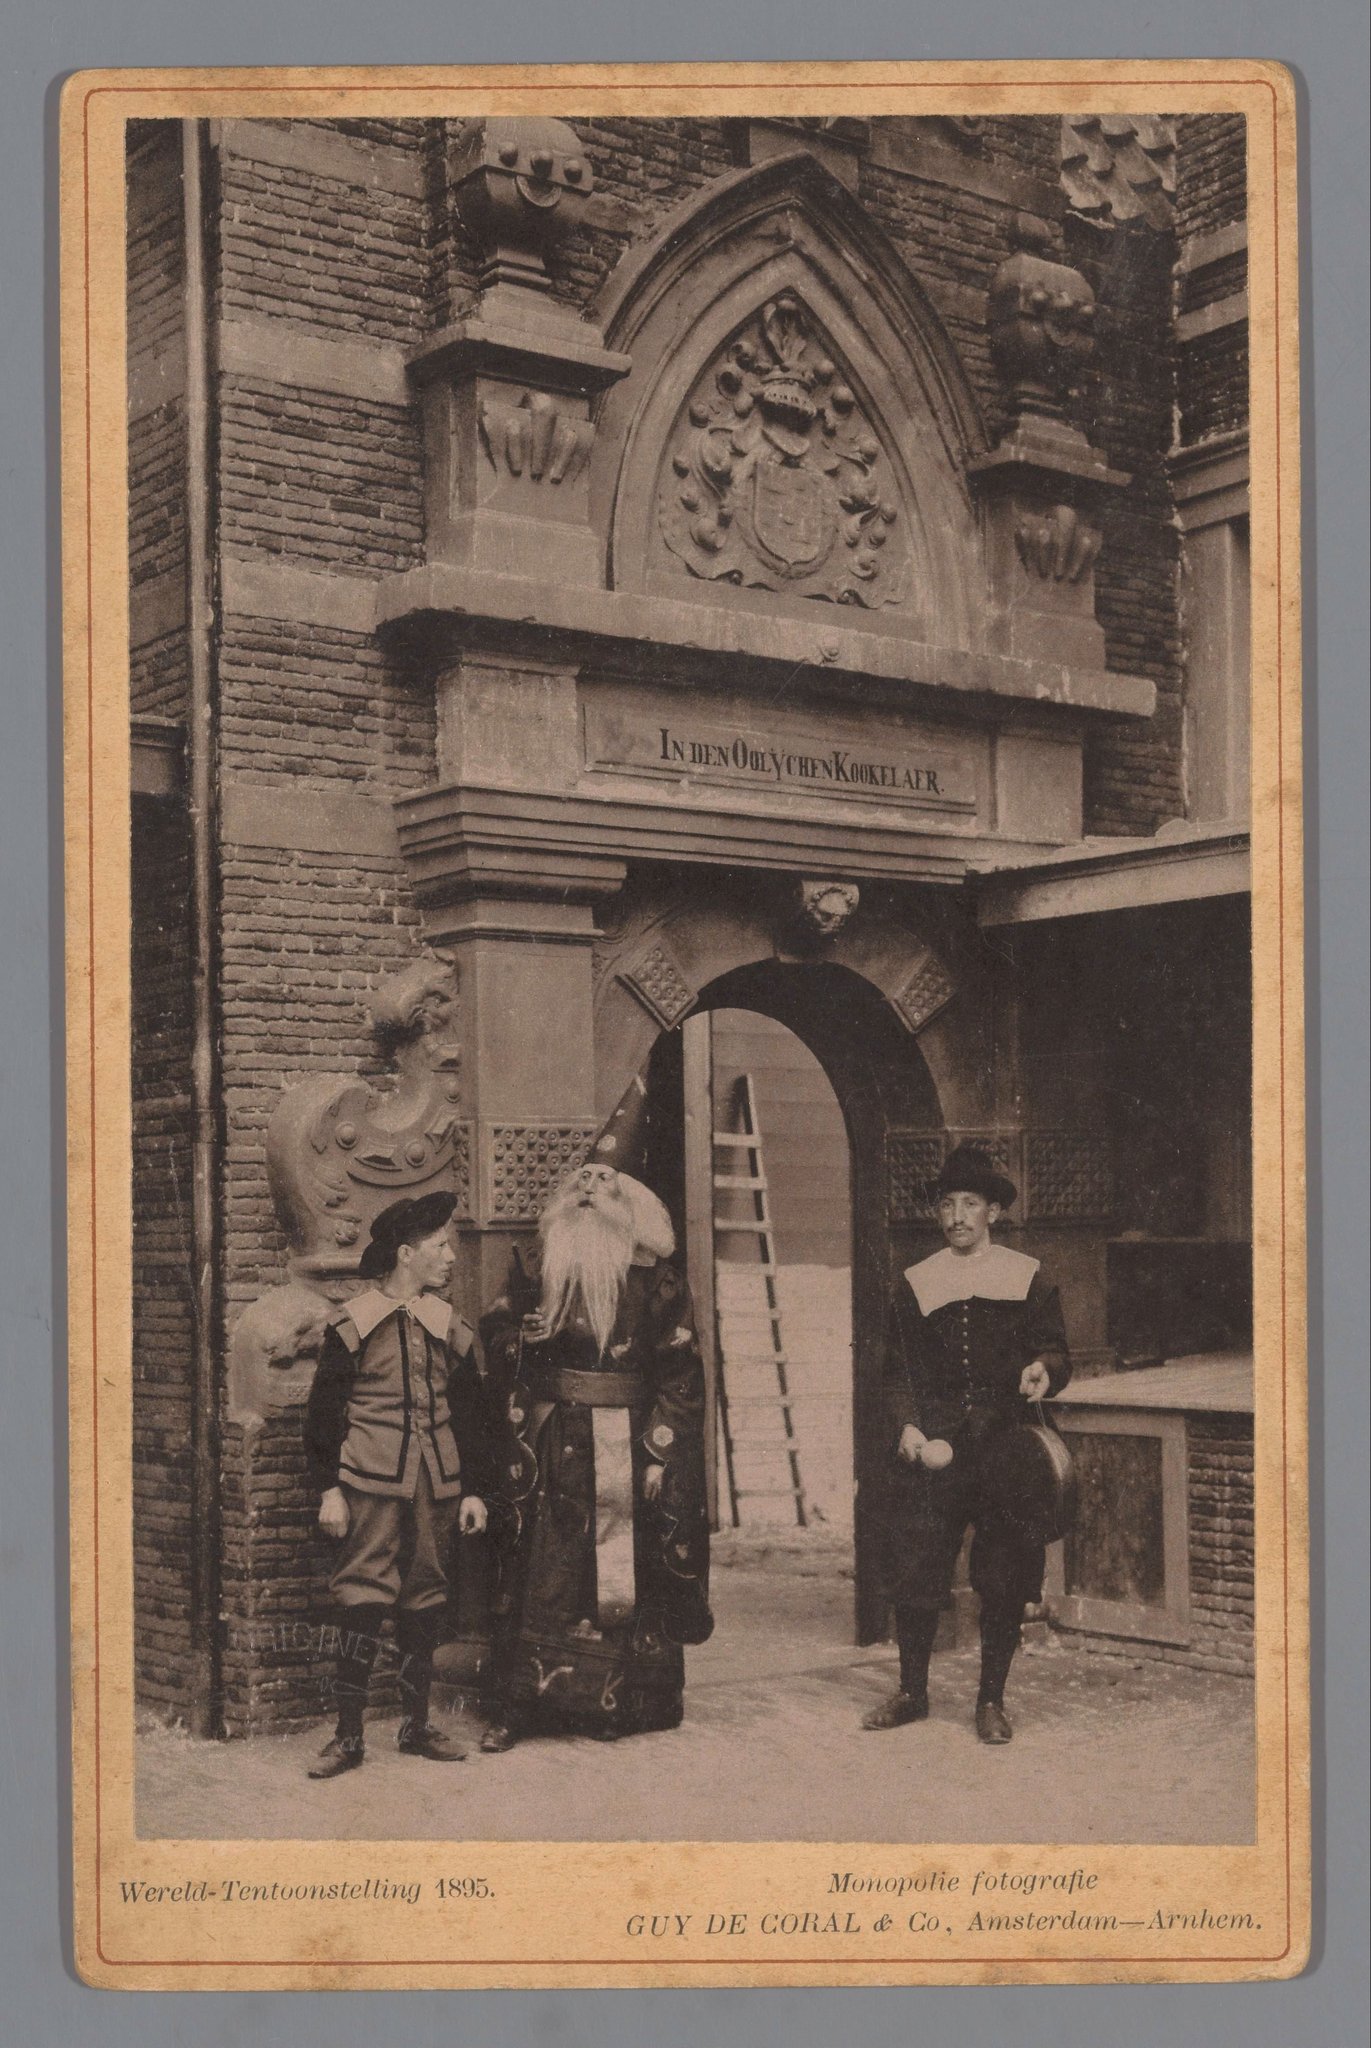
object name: cabinet photograph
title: Drie mannen in kostuum op de Wereldtentoonstelling van 1895 in Amsterdam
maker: Anonymous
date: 1895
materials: cardboard, paper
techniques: photograph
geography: amsterdam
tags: world fair, world exhibition, amsterdam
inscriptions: inscription: ‘Monopolie fotografie/ GUY DE CORAL & CO, Amsterdam - Arnhem.’